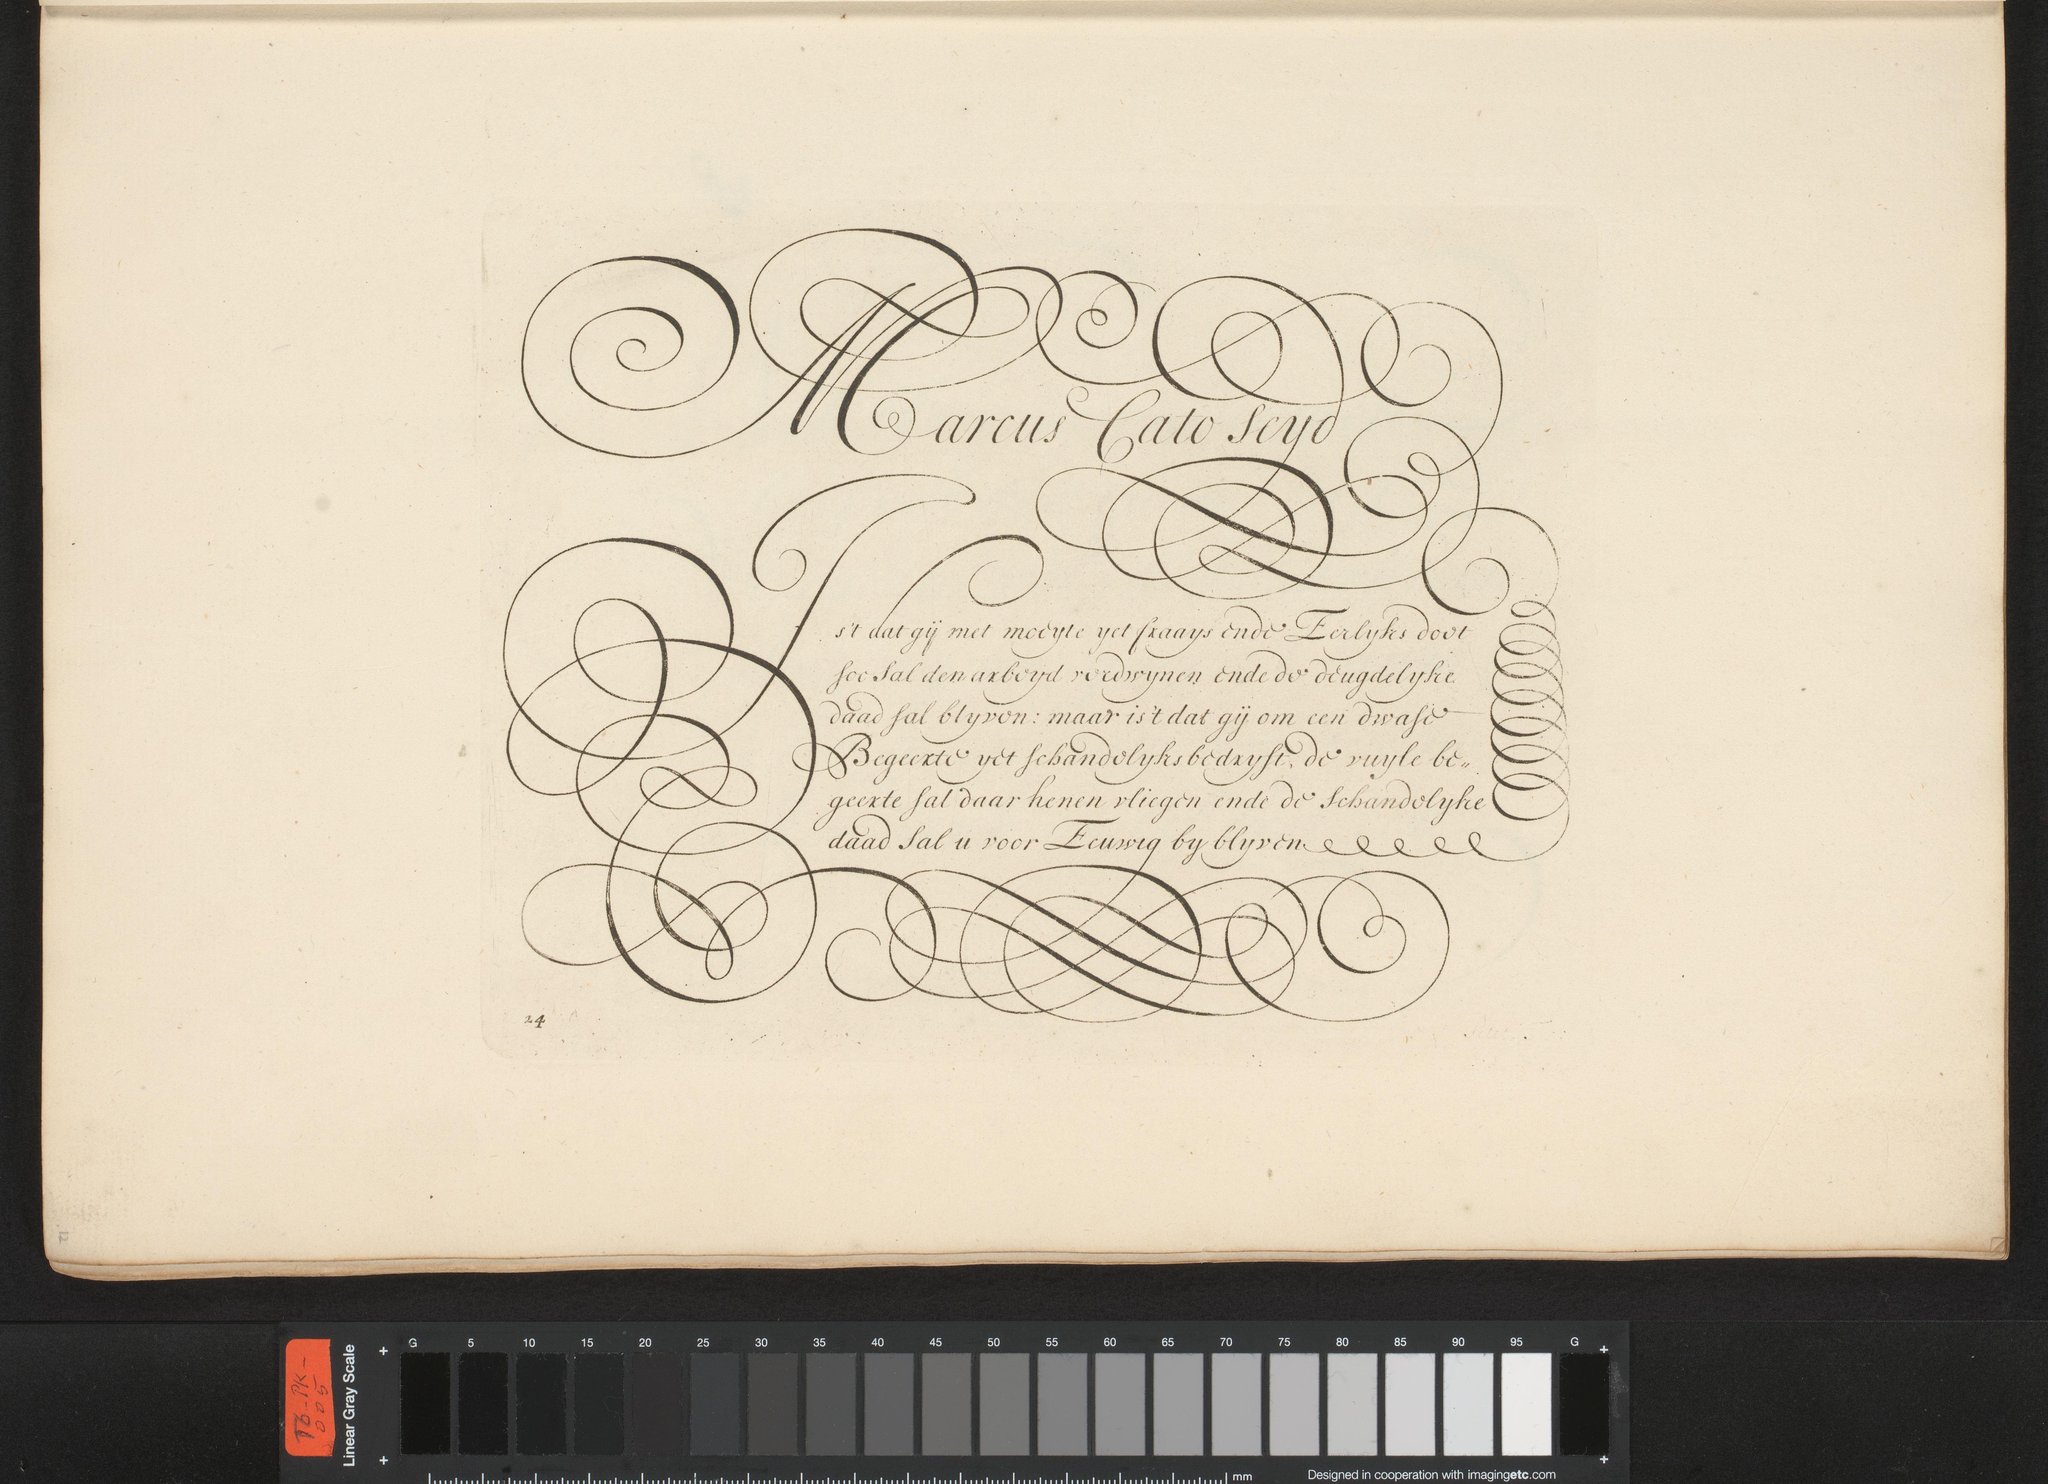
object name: ornament print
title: Schrijfvoorbeeld: Marcus Cato Seyd (...)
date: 1660-1751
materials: paper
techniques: engraving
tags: calligraphy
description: Schrijfvoorbeeld met zeven regels tekst in het Nederlands: Marcus Cato Seyd ... De prent maakt deel uit van een album